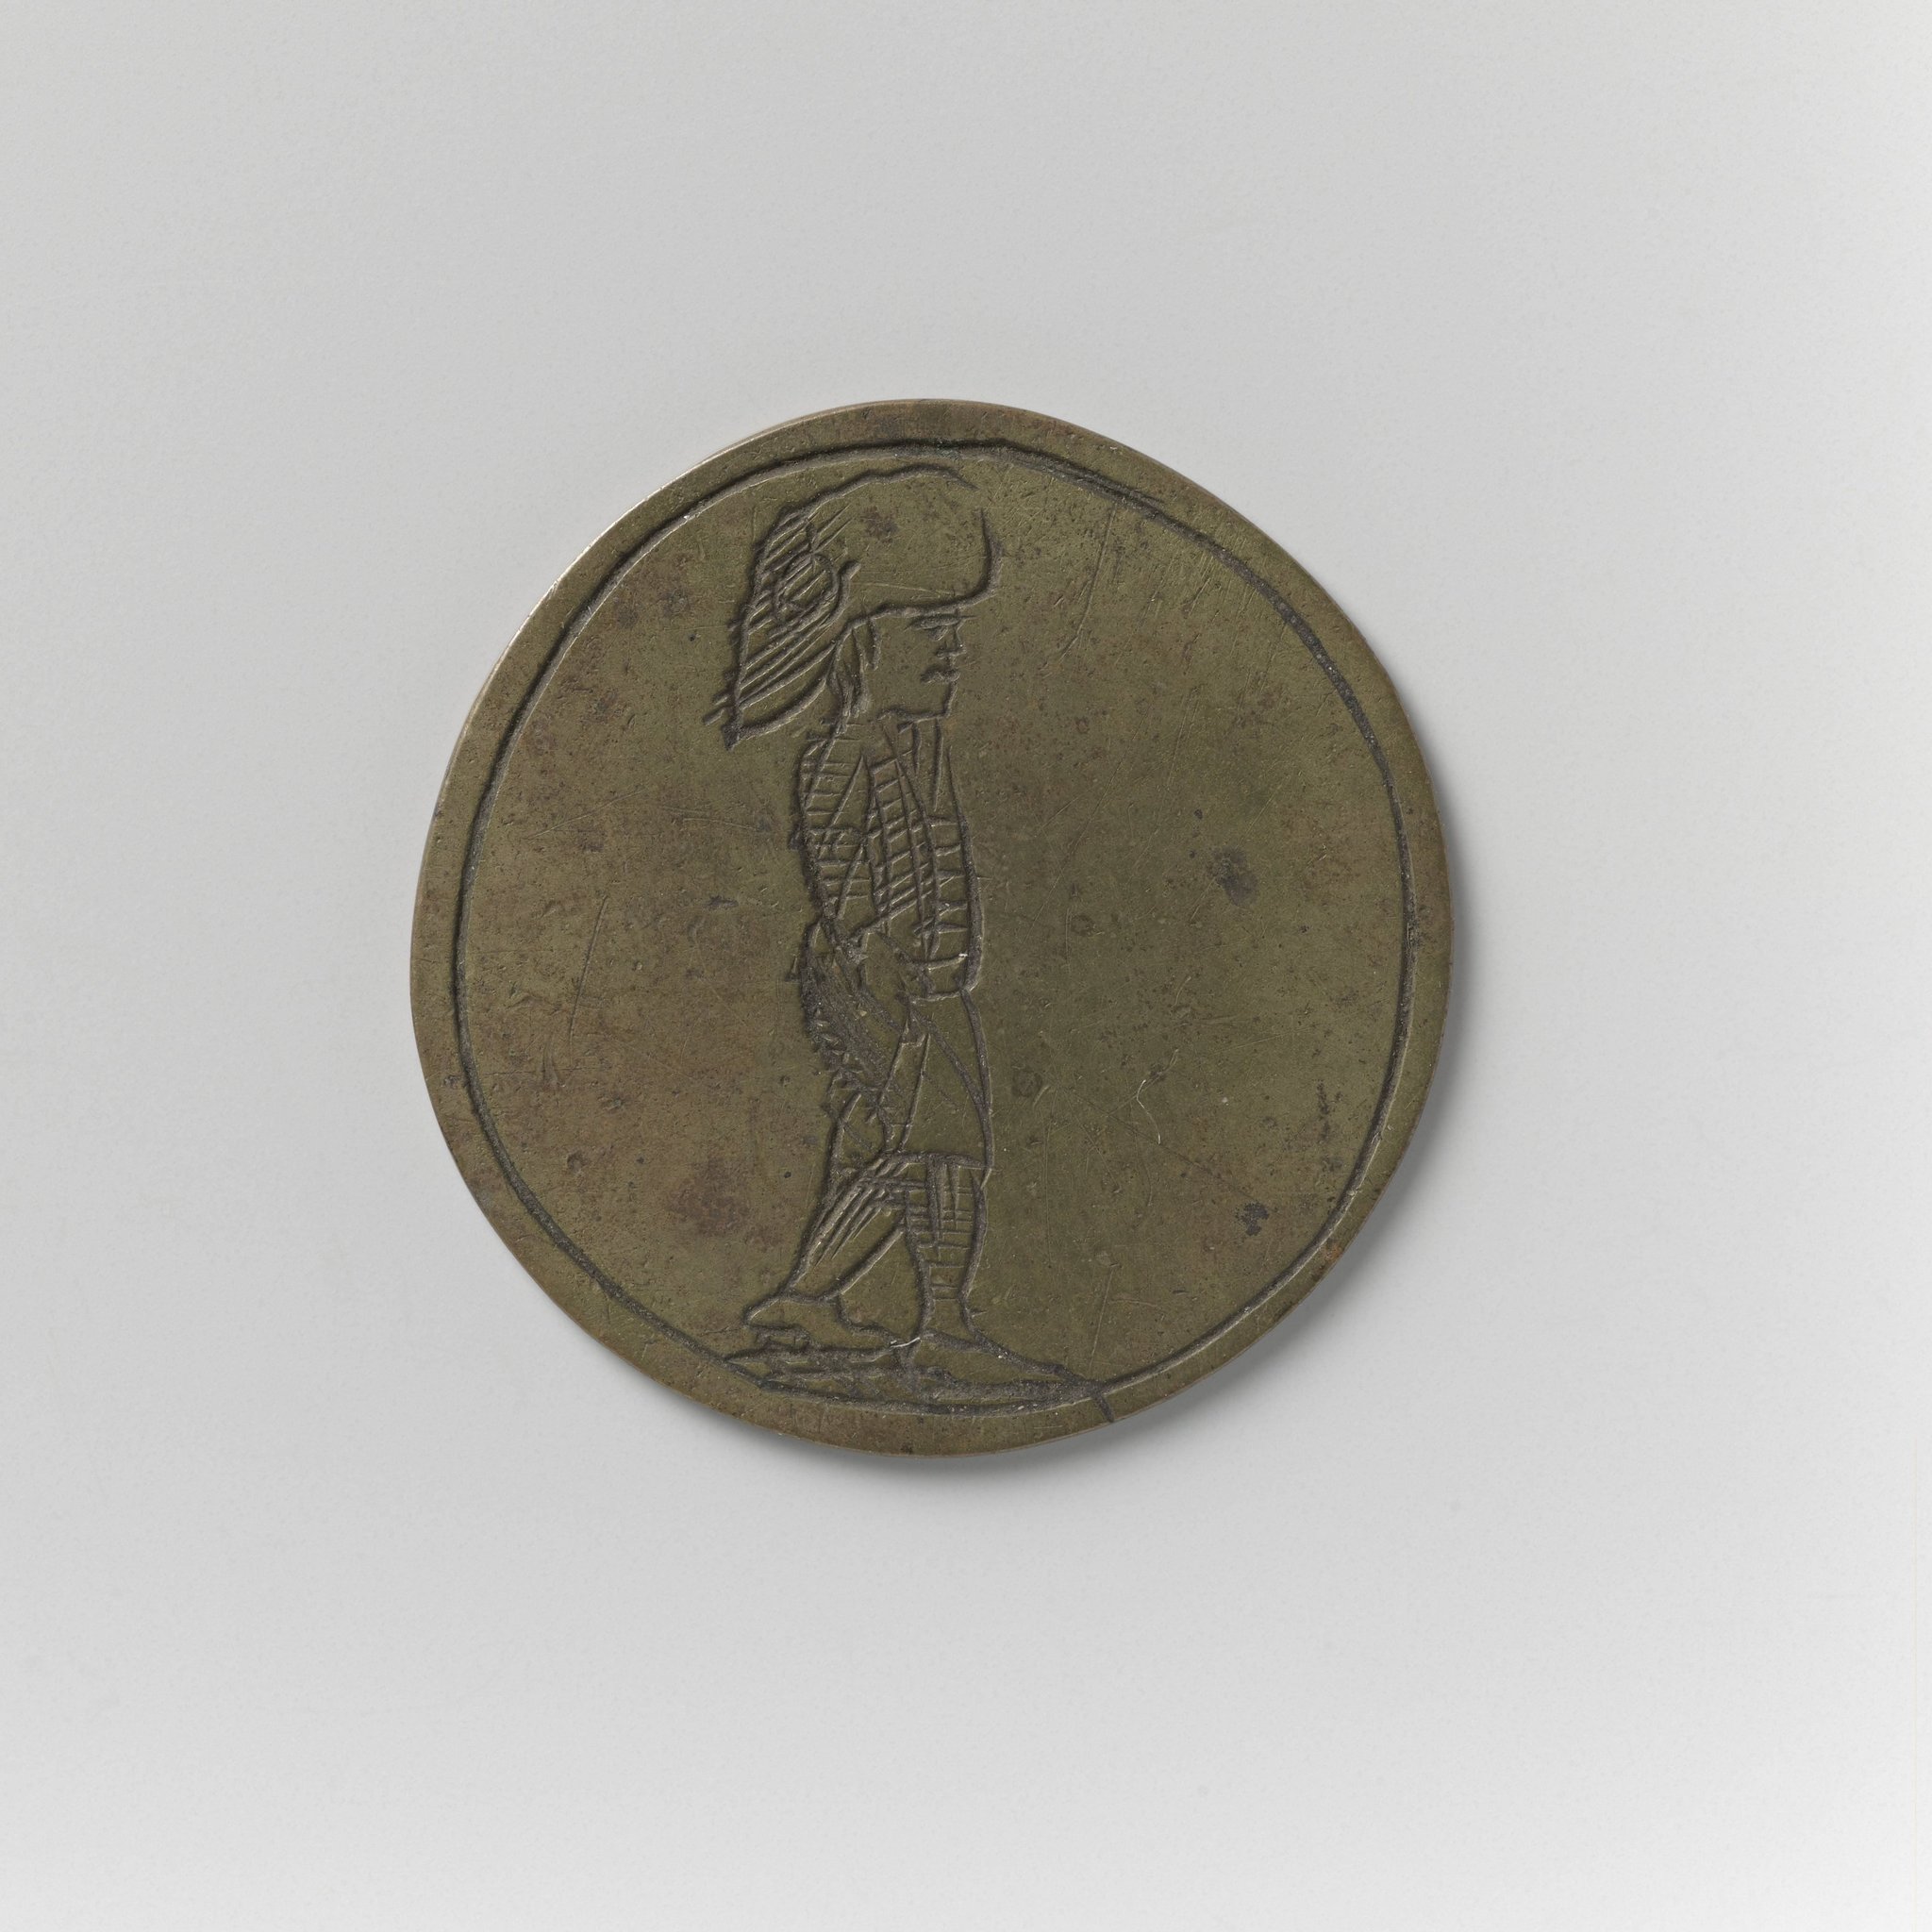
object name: medal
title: Korendragers- en -stortersgilde van Amsterdam, gildepenning van Coenraad de Ruyter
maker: Anonymous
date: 1759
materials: brass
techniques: engraving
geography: amsterdam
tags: amsterdam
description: Messing penning. Voorzijde: naar rechts gewende man met last op hoofd. Keerzijde: opschrift